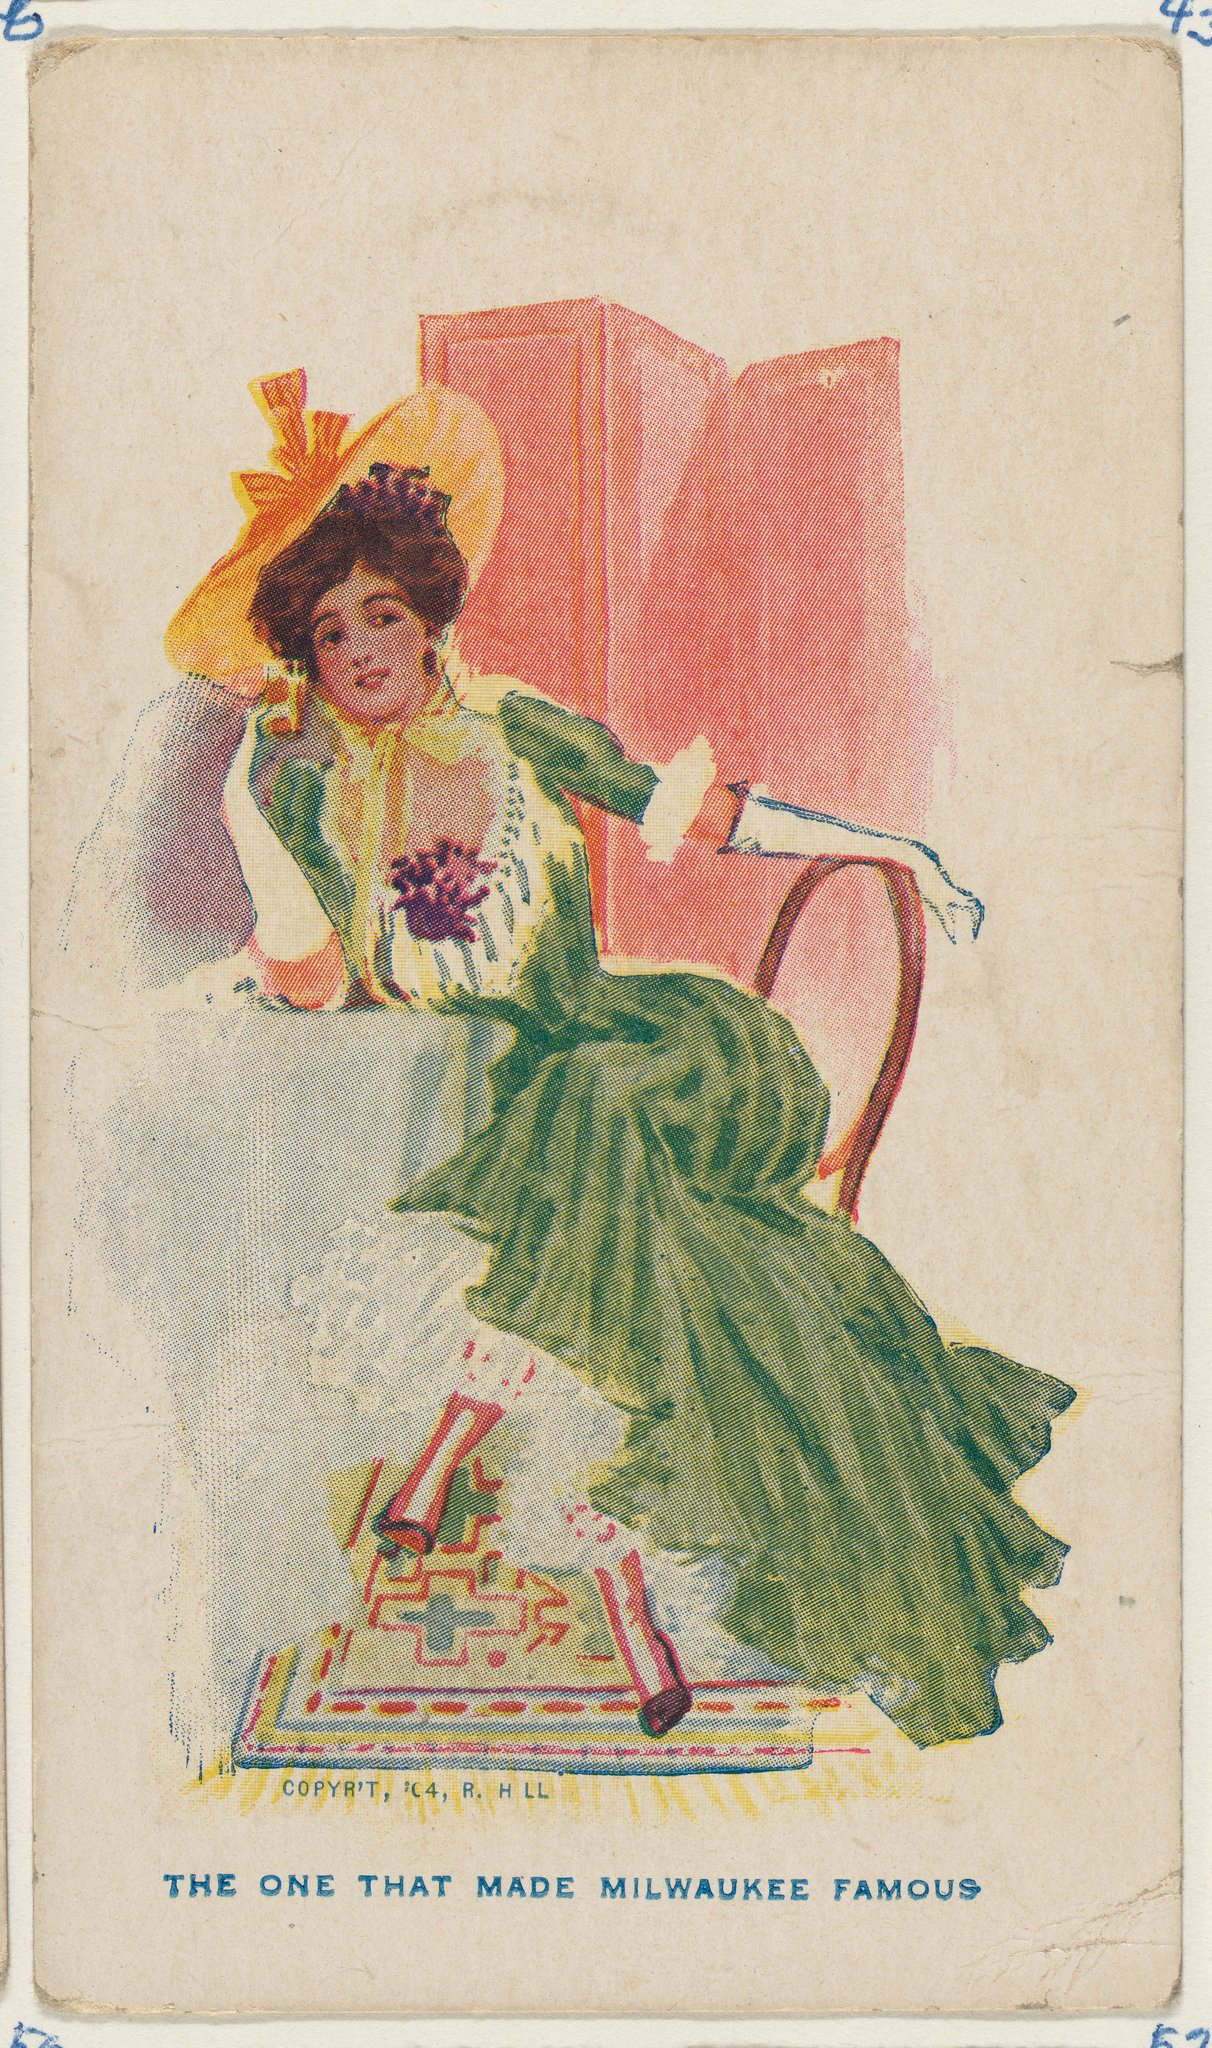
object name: print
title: The one that made Milwaukee famous, from the "Girls and Men in Costume" series (T65), issued with Golden Eagle Cigars by I. Lewis & Co.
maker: i. lewis & co., newark, new jersey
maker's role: publisher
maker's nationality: american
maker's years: 1850-1950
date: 1903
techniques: color lithograph